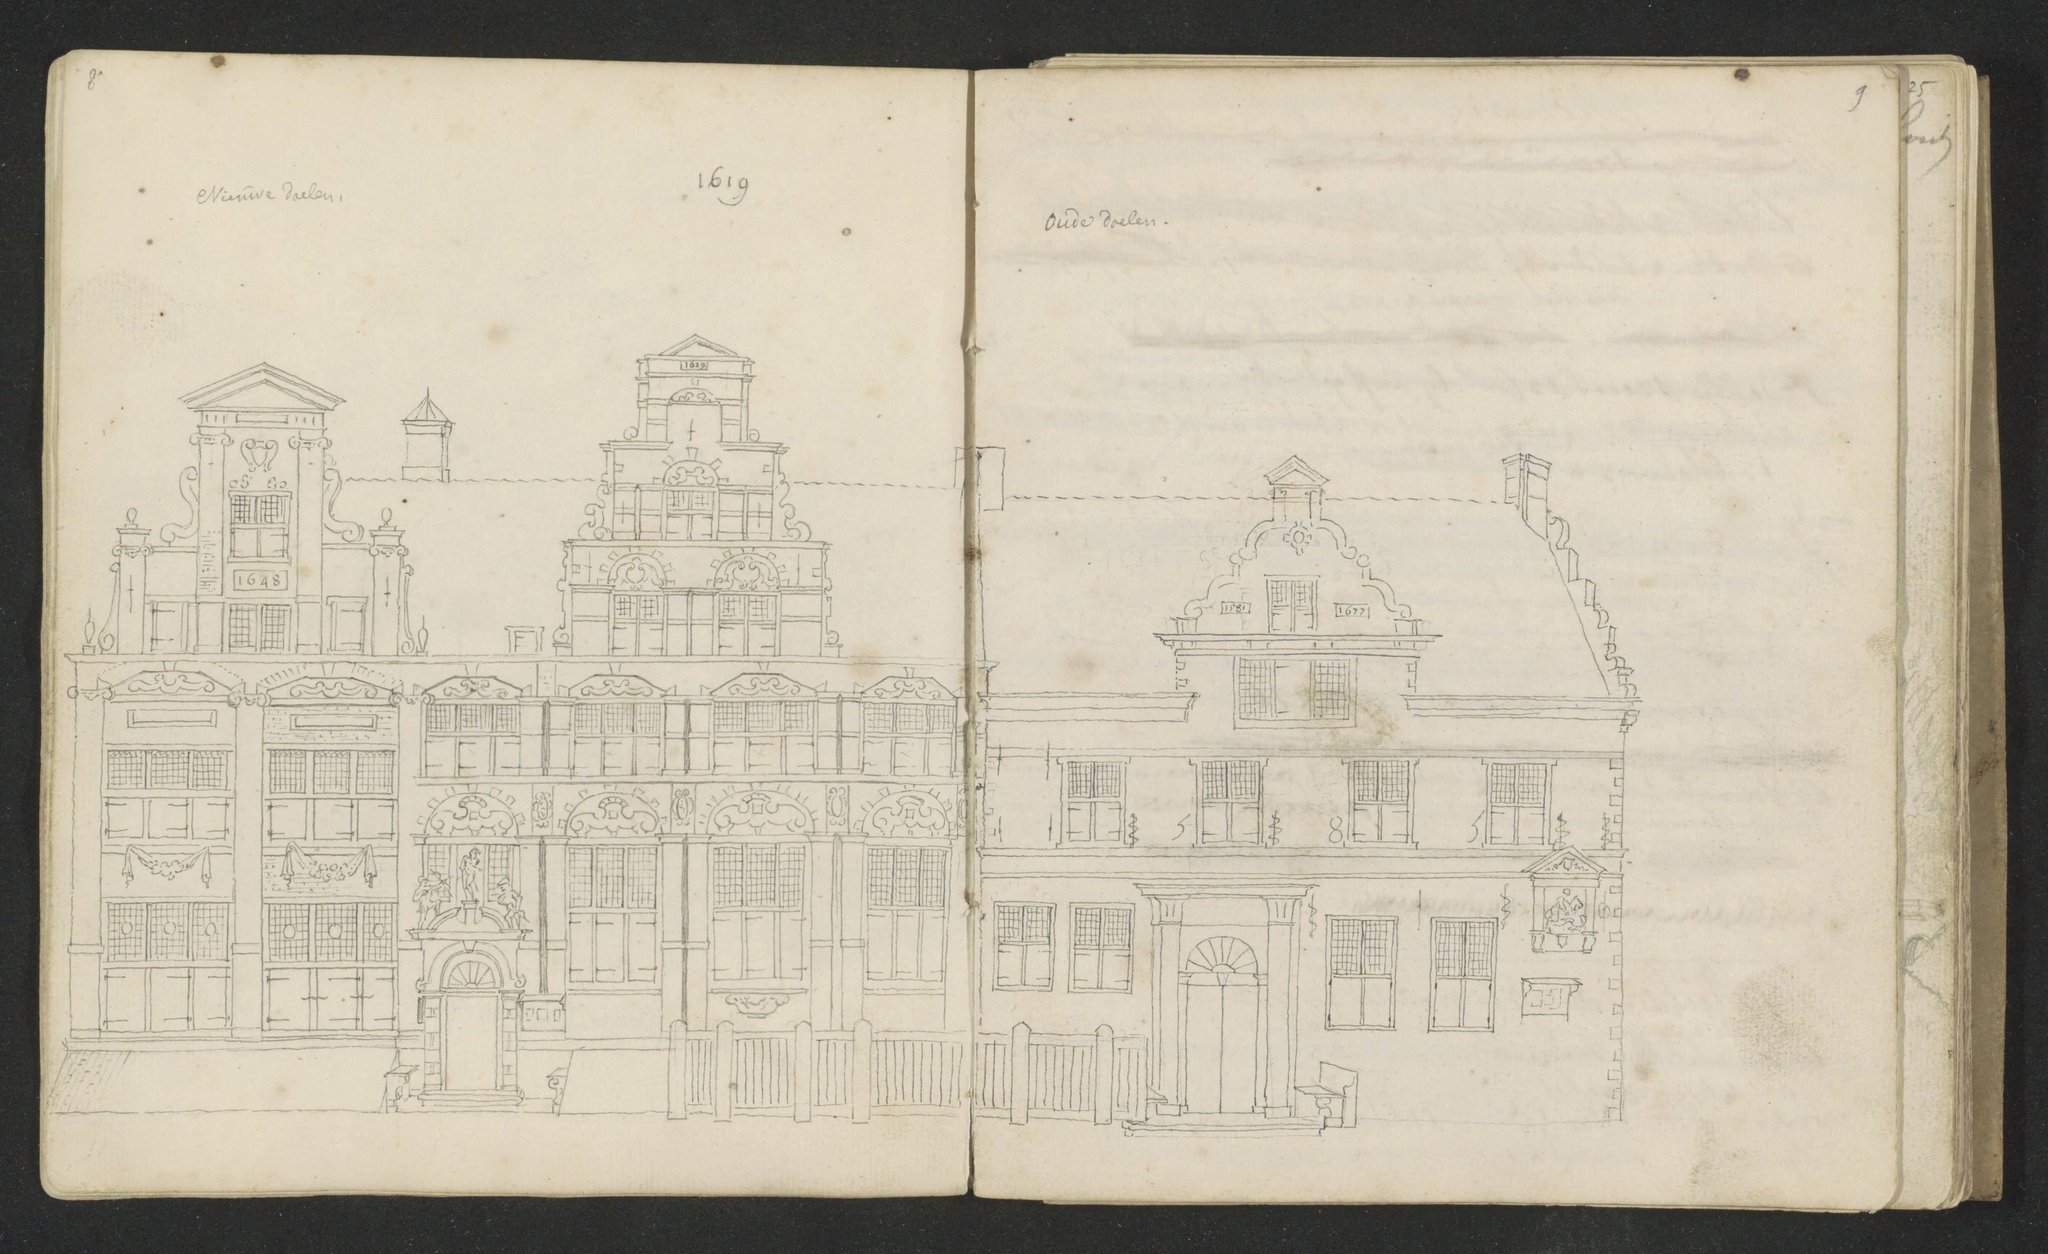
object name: sketchbook leaf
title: Opstand van de gevels van de Nieuwe Doelen en Oude Doelen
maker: cornelis pronk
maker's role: draughtsman, painter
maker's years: 1691-1759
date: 1728-1732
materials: paper, pencil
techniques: pen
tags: façade (of house or building)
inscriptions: annotation: ‘Nieuwe doelen 1619/ Oude doelen/ 1648/ 1629/ 1581 1677’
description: Bladzijde 8 en 9 uit een schetsboek met 96 bladzijden.